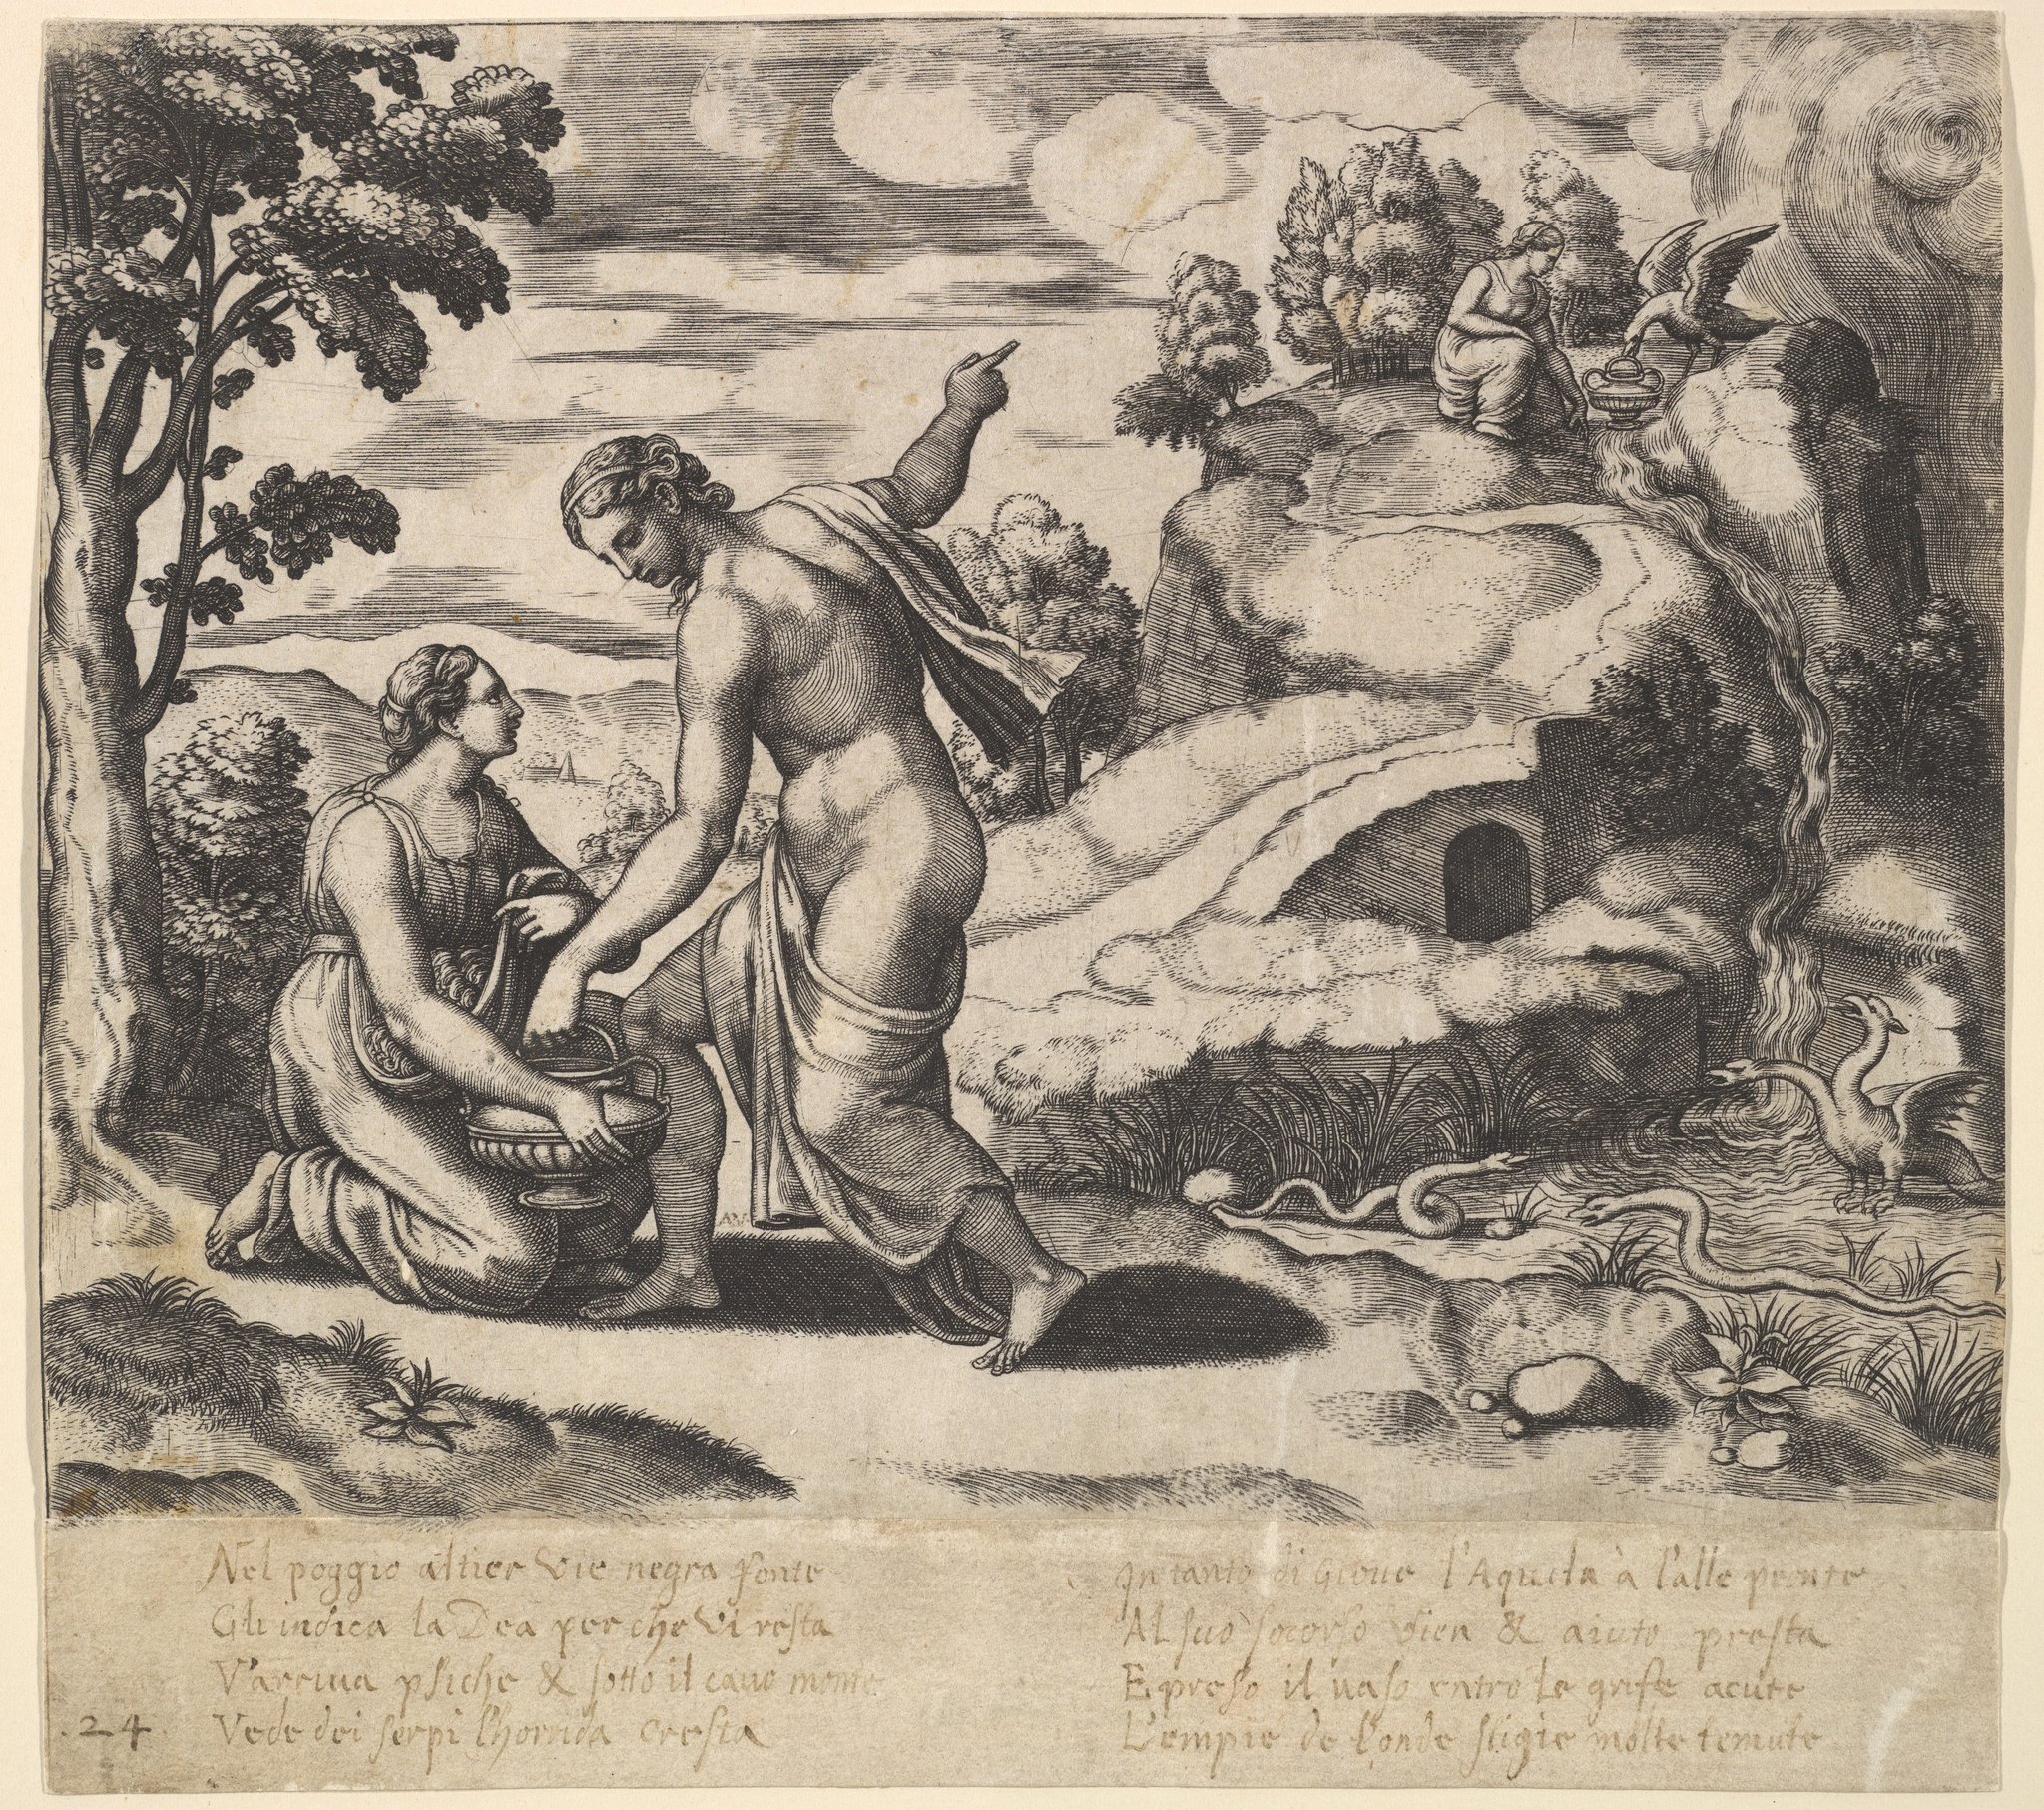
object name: print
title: Venus ordering Psyche to take water from a fountain guarded by dragons, from "Fable of Cupid and Psyche"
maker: master of the die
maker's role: artist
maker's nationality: italian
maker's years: 1525-1560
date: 1530-1560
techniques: engraving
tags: fountains,psyche,venus